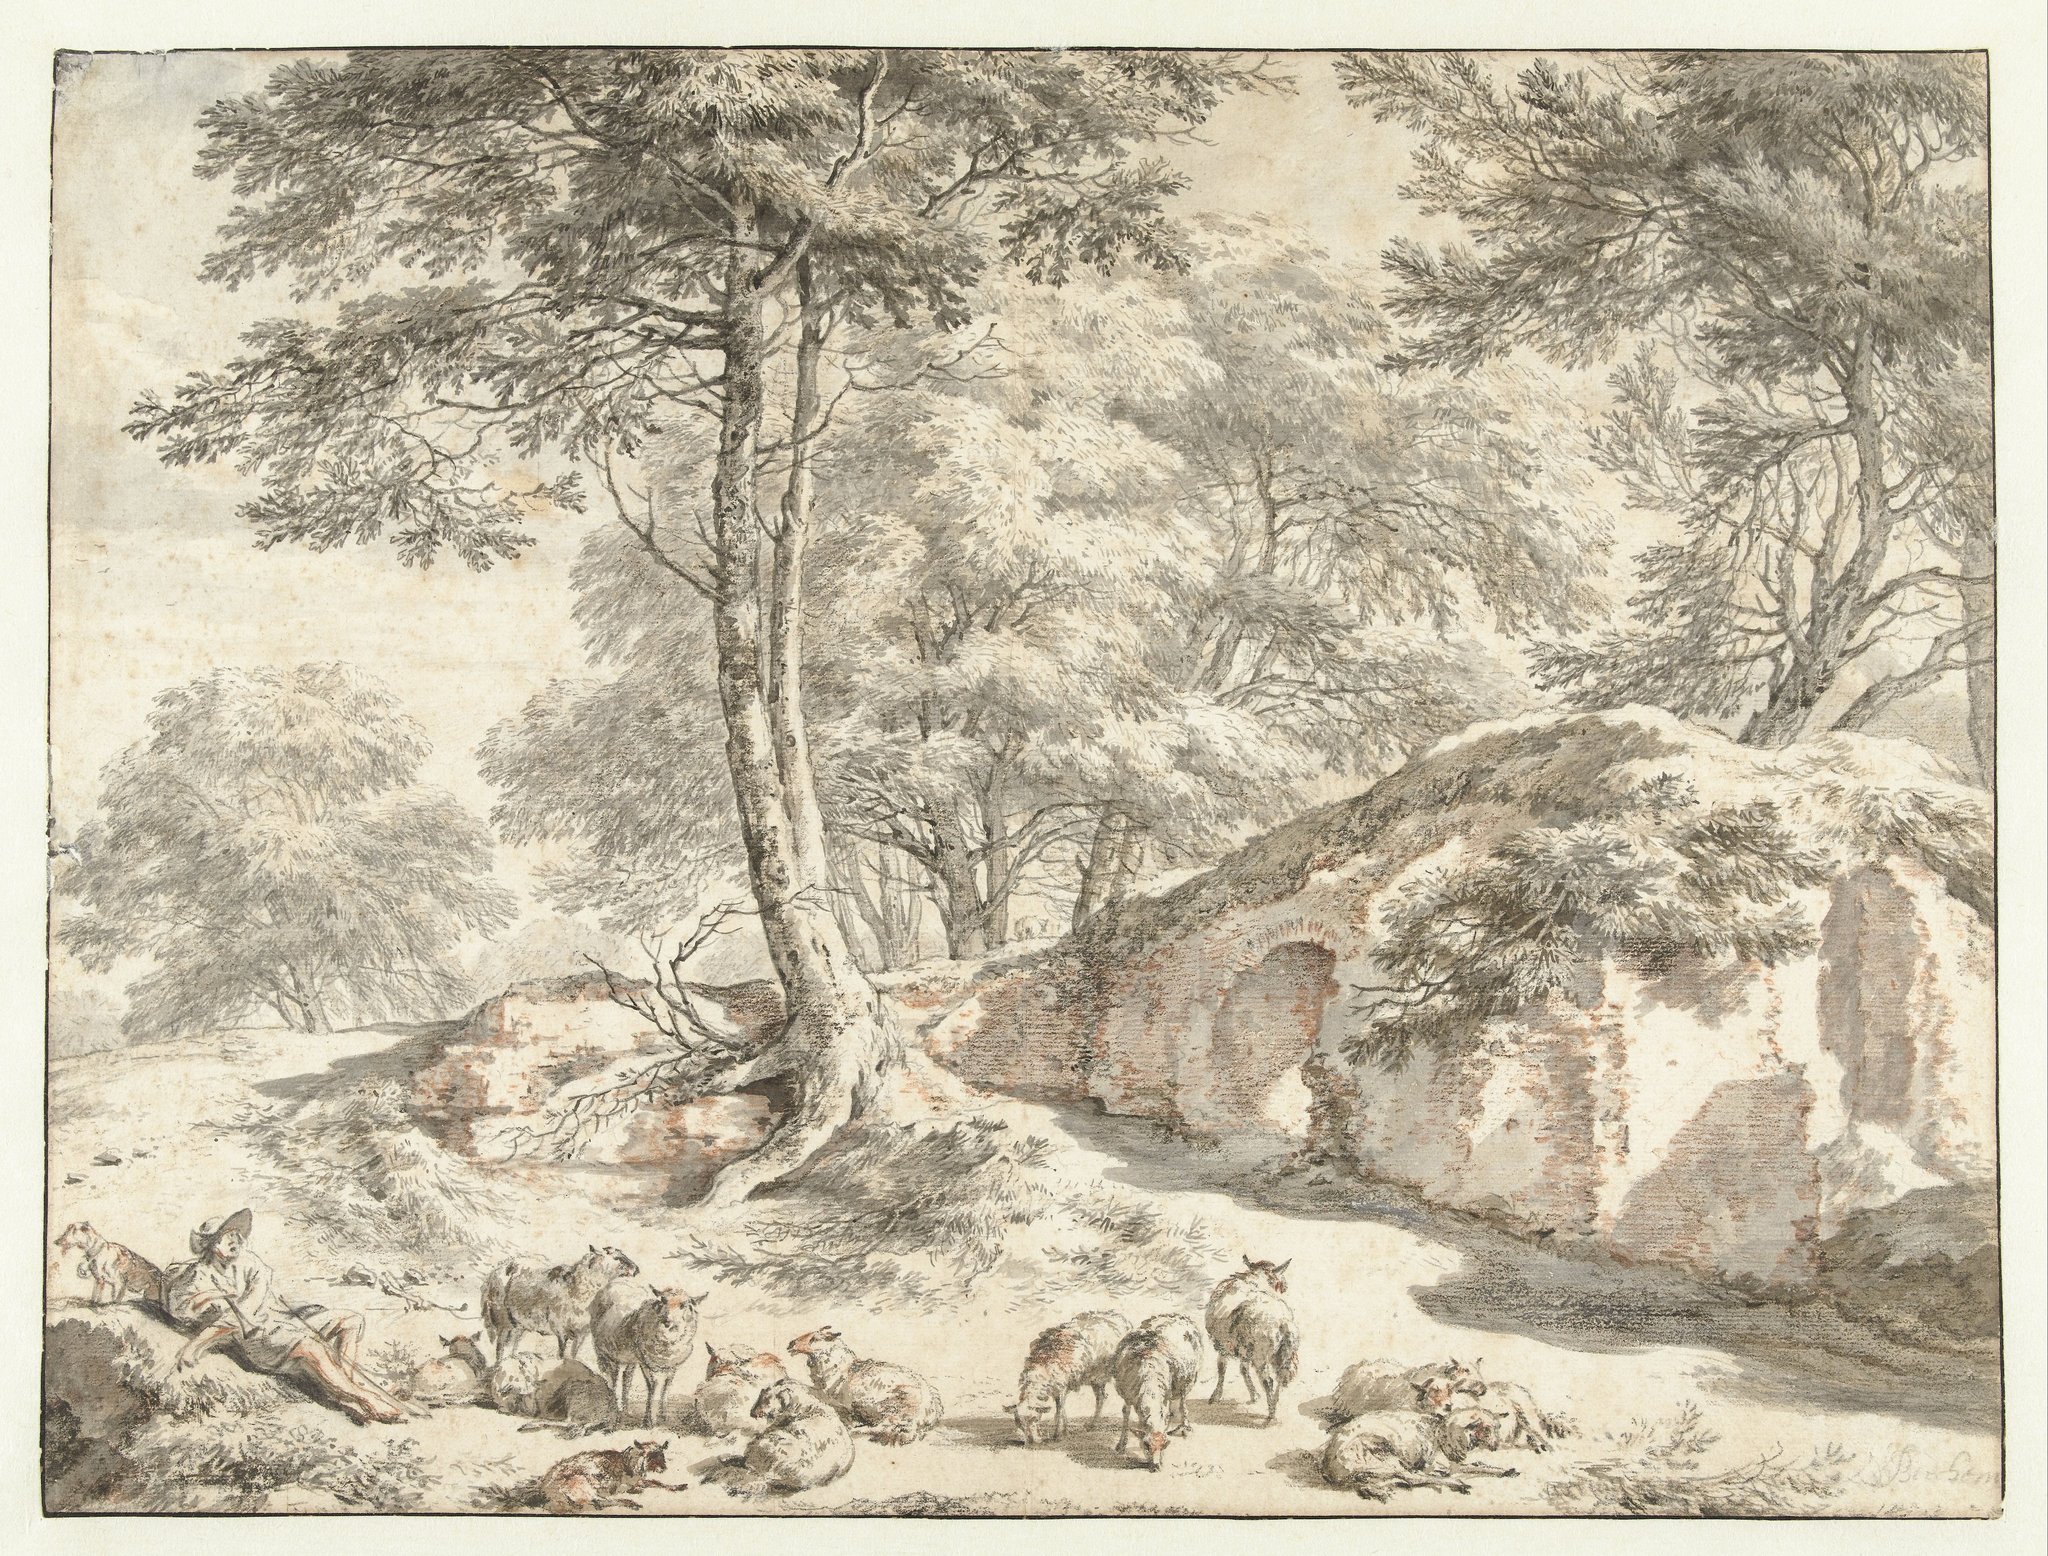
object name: drawing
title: Herder met schapen bij een ruïne tussen bomen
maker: nicolaes pietersz berchem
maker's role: draughtsman, print maker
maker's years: 1620-1683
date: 1665-1675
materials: chalk, charcoal, paper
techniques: brush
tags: herding, herdsman, herdswoman, shepherd, shepherdess, cowherd, etc., landscape with ruins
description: Herder met schapen bij de ruïne van Brederode (?) tussen bomen.